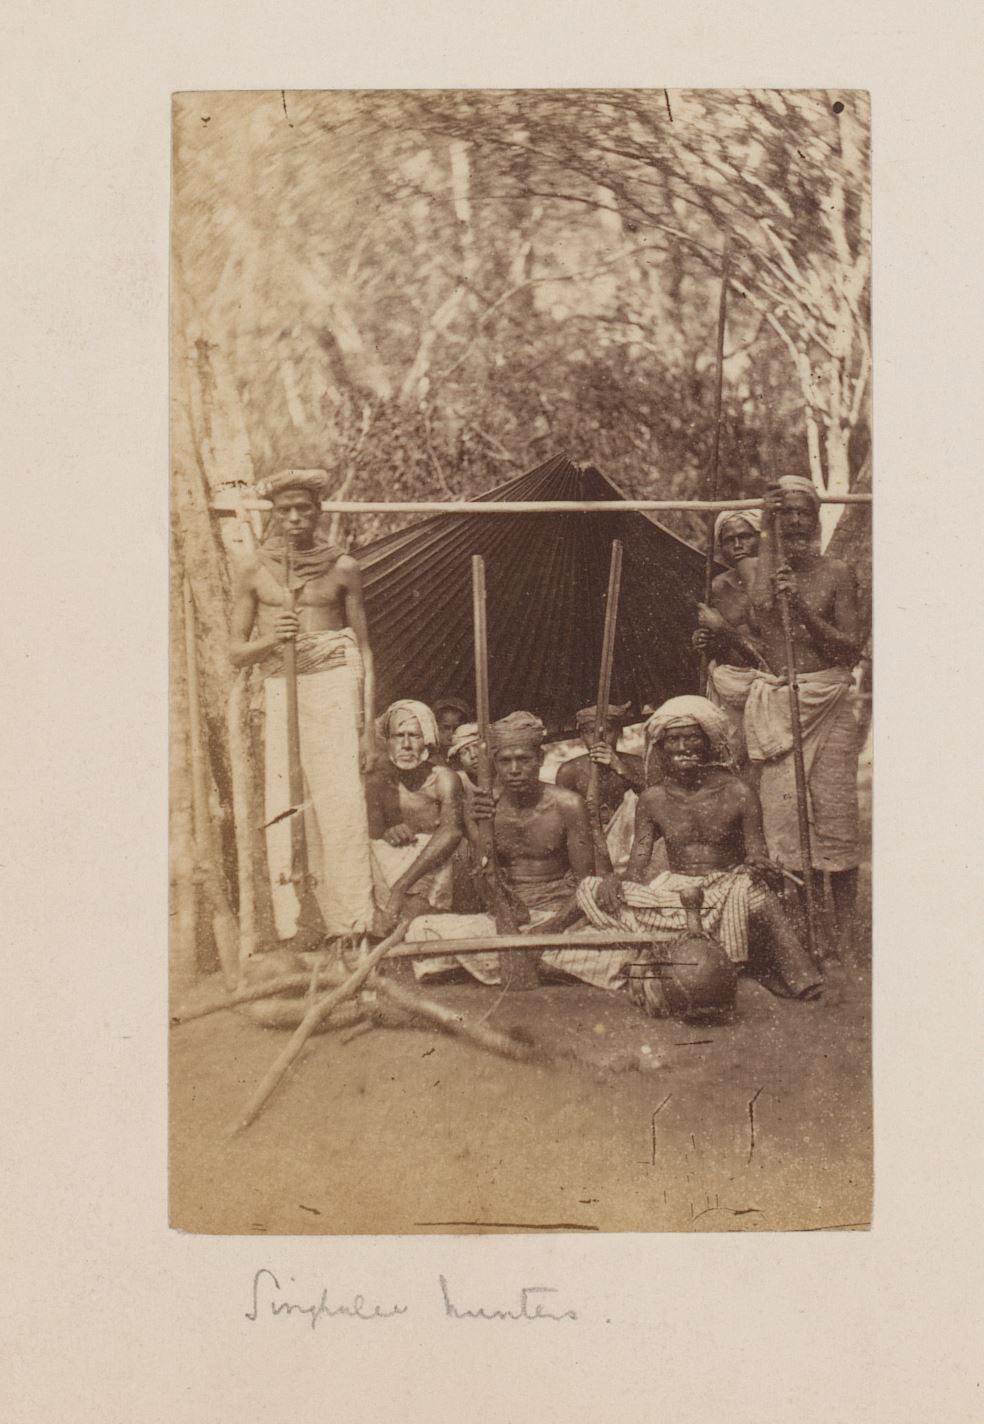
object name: album leaf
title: Hunters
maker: Anonymous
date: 1880-1900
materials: cardboard, paper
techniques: albumen print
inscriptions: caption: ‘Simphalee hunters.’, number: ‘1596’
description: Jagers, 'Symphalee hunters', waarvan drie staand en de overigen zittend, poserend met stokken en geweren. Object zit samen met de andere foto's met nummer RP-F-00-6678 op één blad geplakt.